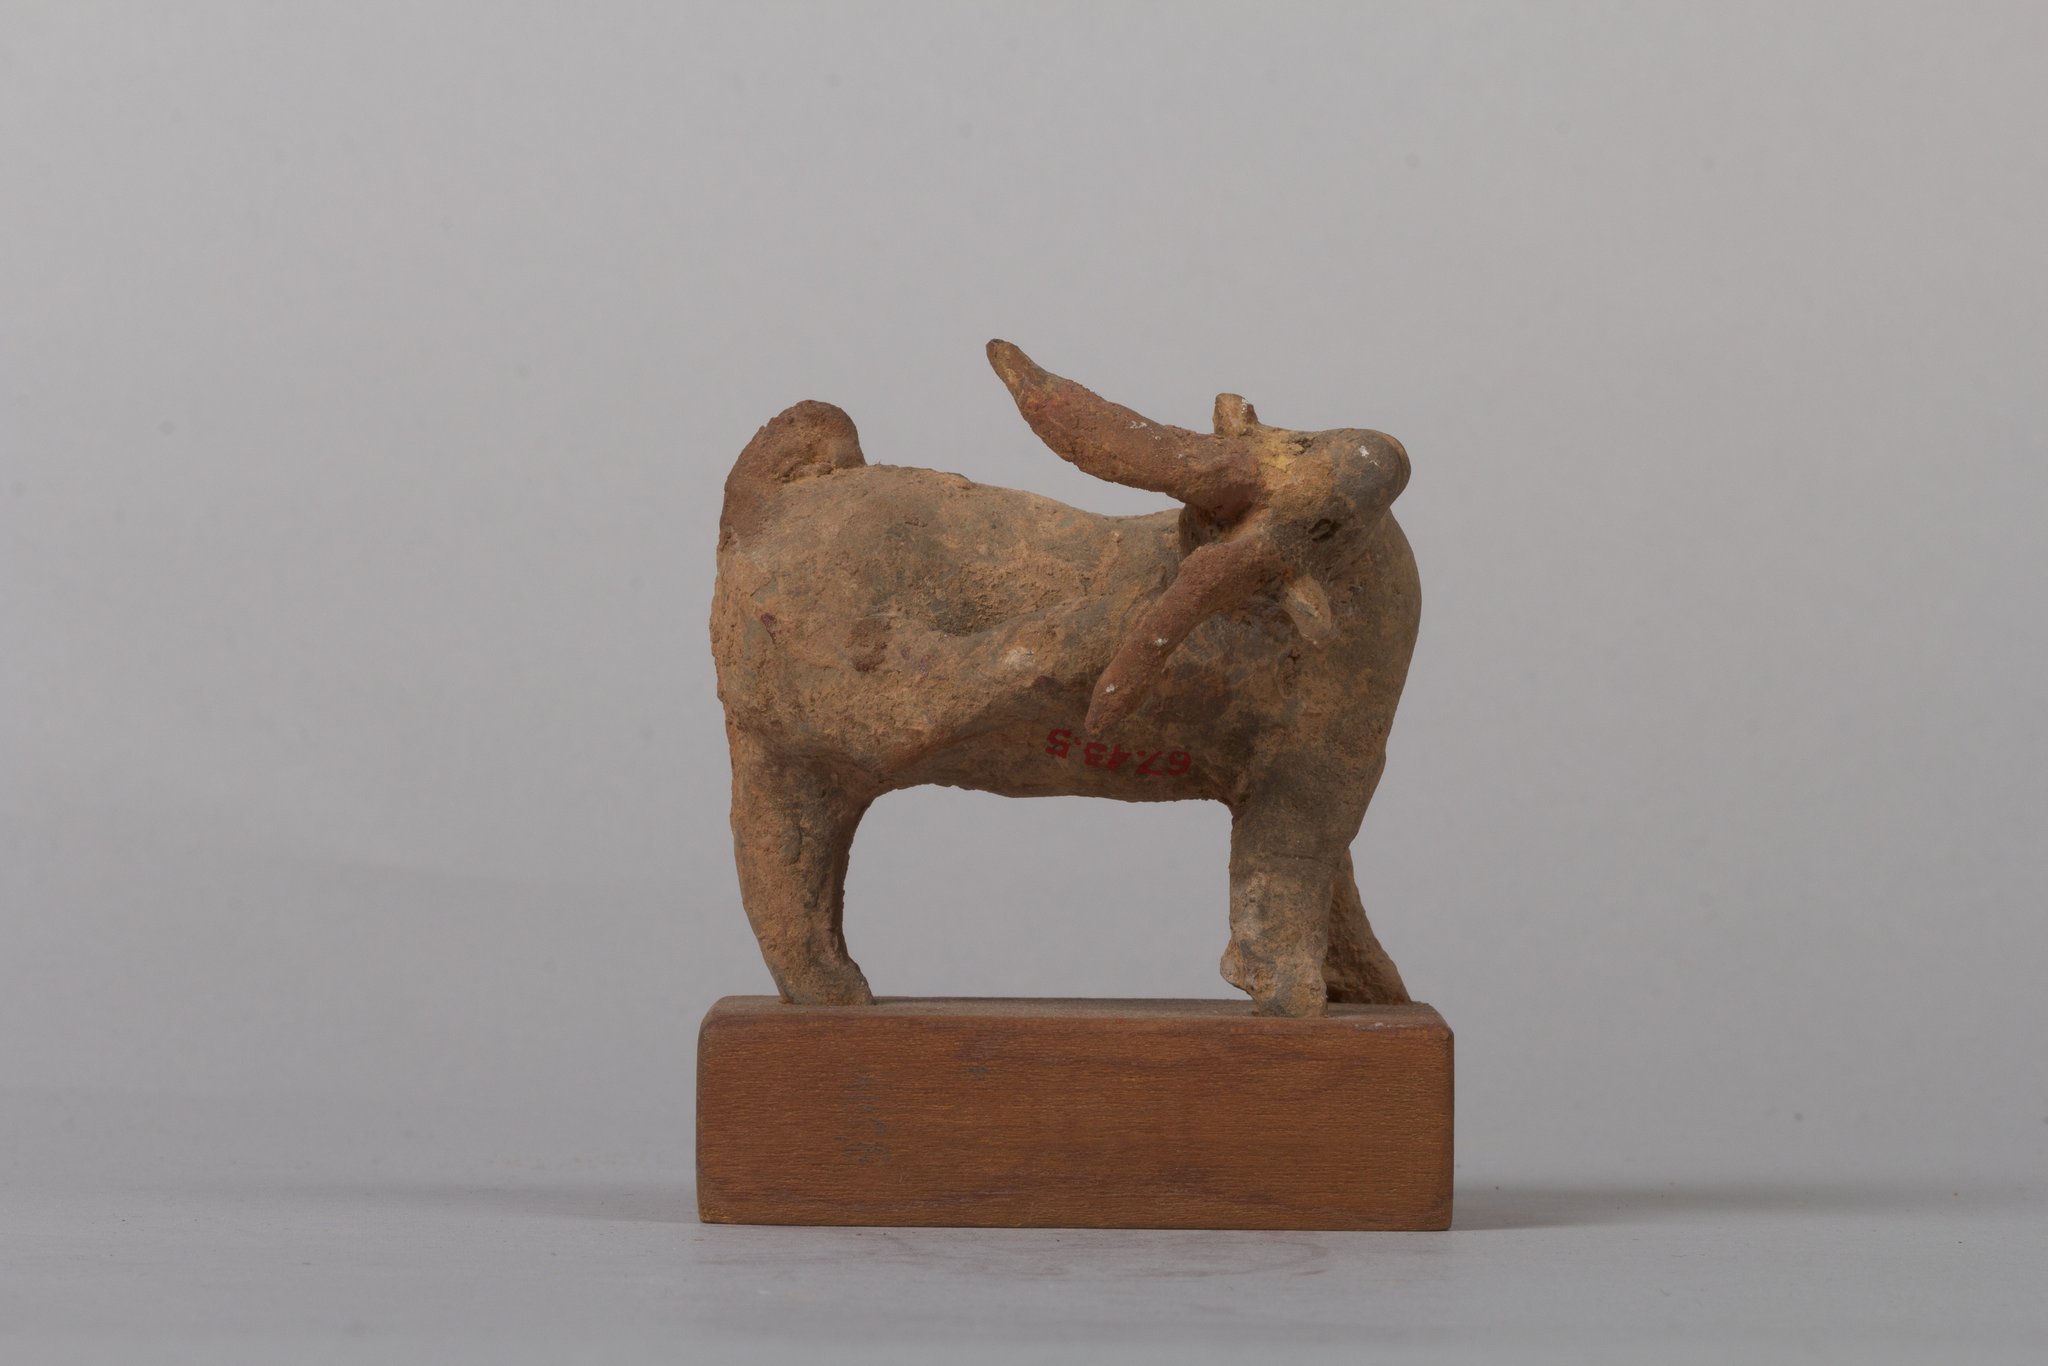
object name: figure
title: Goat (one of a pair)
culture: chinese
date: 501-600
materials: earthenware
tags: goats